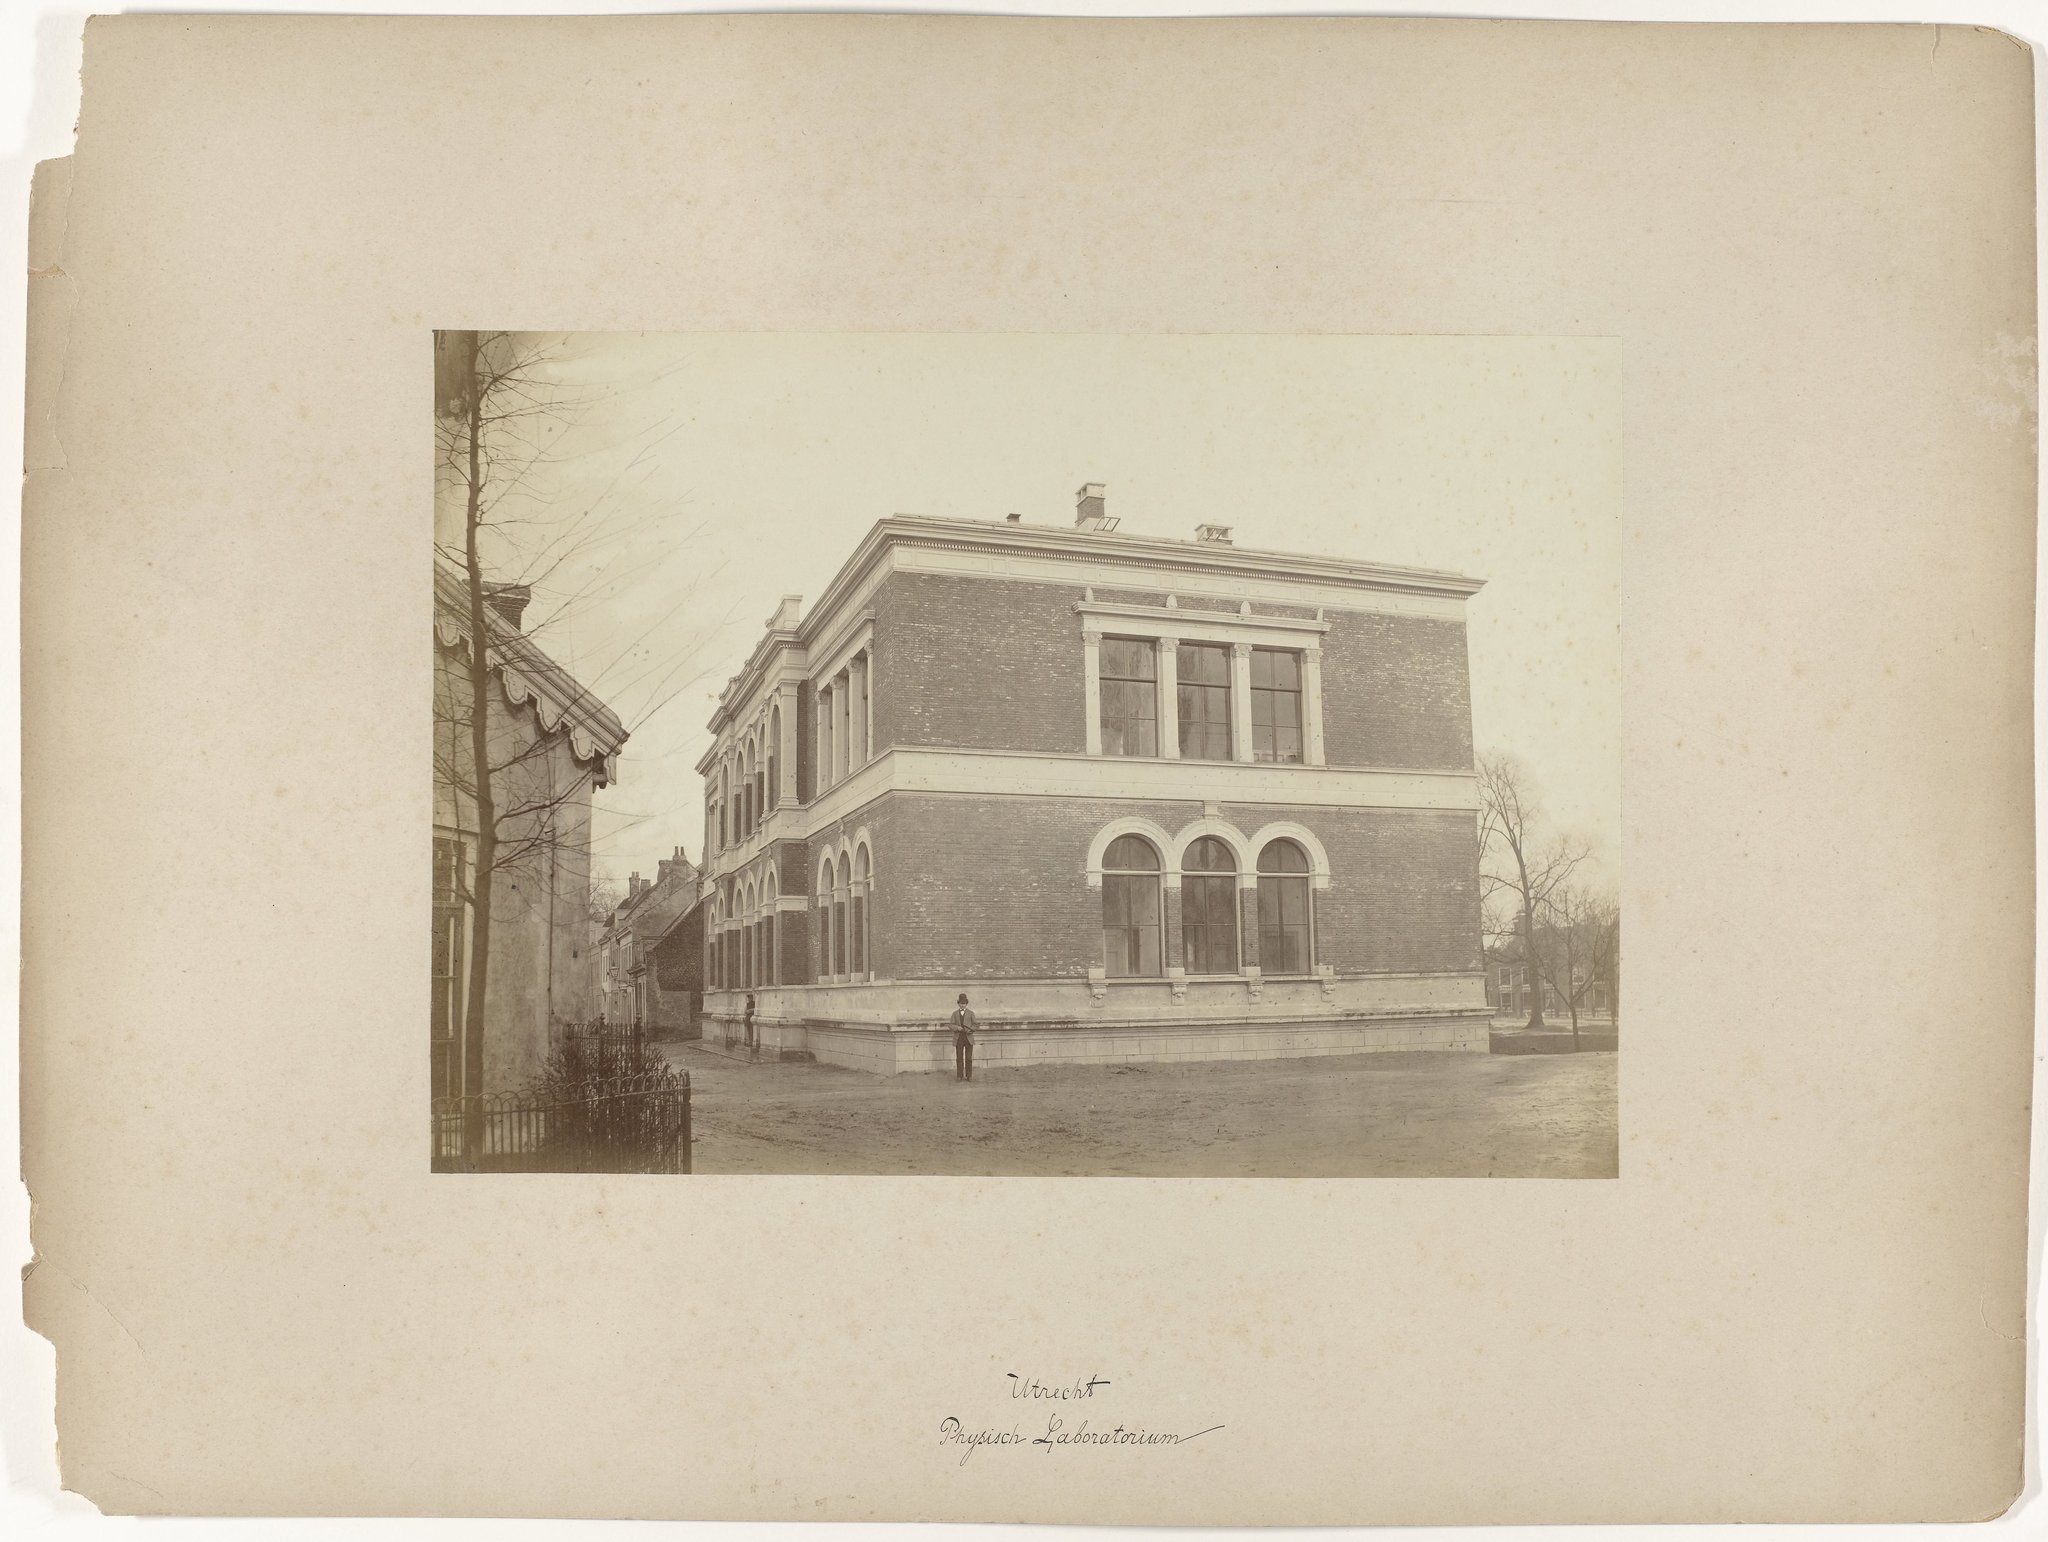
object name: photograph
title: Gezicht op het Physisch Laboratorium in de Bijlhouwerstraat in Utrecht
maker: eduard françois georges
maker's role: sculptor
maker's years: 1817-1895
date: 1877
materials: cardboard, photographic support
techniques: albumen print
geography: utrecht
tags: laboratory, university, utrecht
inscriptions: inscription